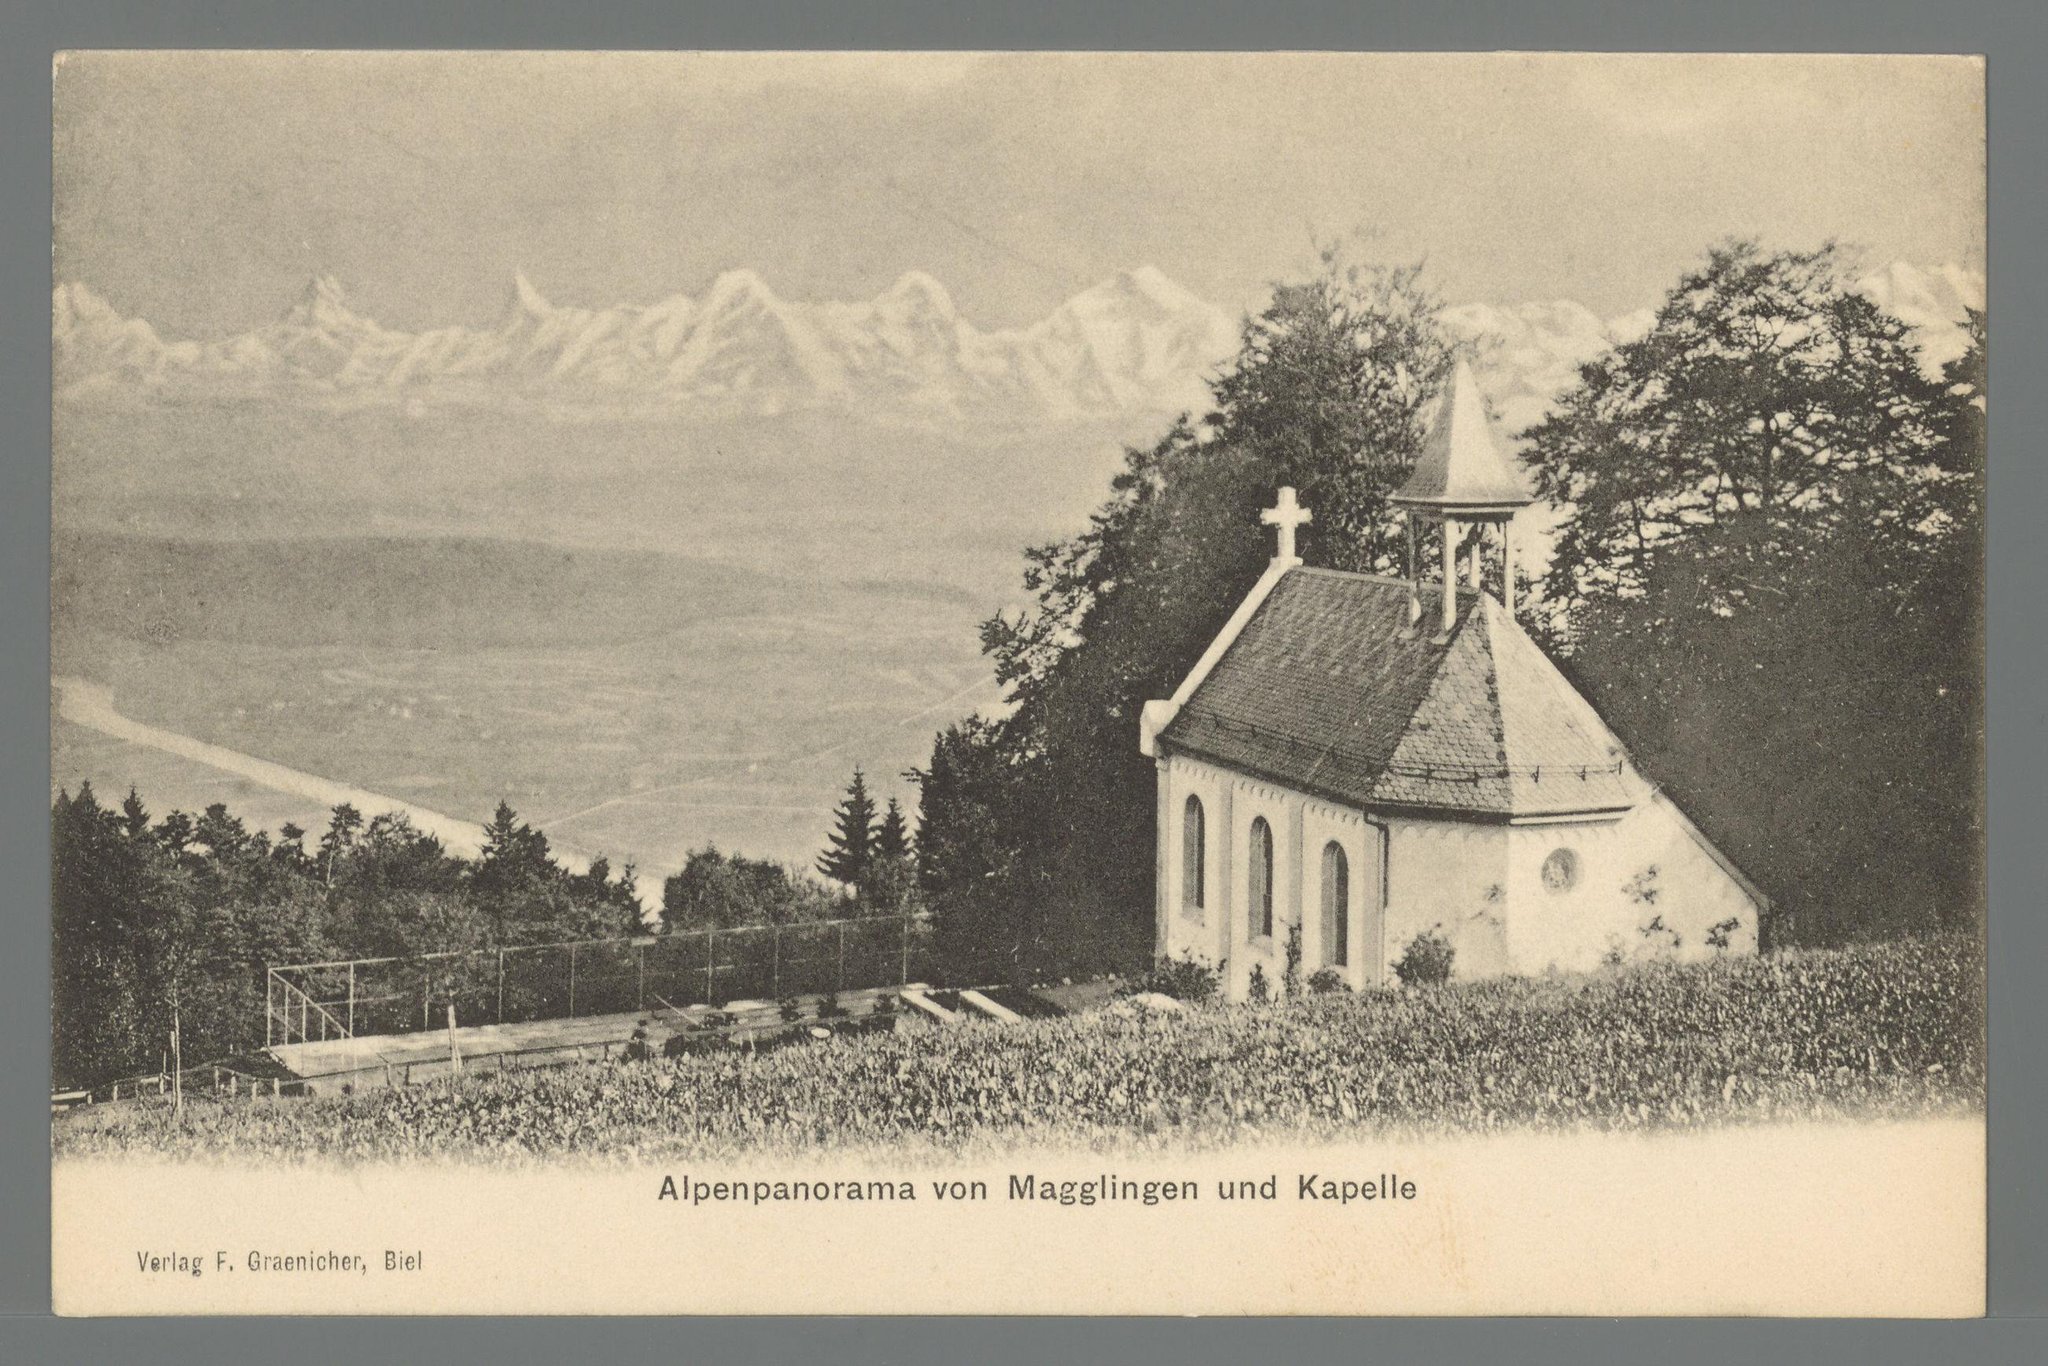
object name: ansichtkaart, prentbriefkaart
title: Alpenpanorama von Magglingen und Kapelle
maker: Anonymous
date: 1890-1905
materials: cardboard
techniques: photograph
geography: biel/bienne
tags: church (exterior), mountain-range, snow peaks